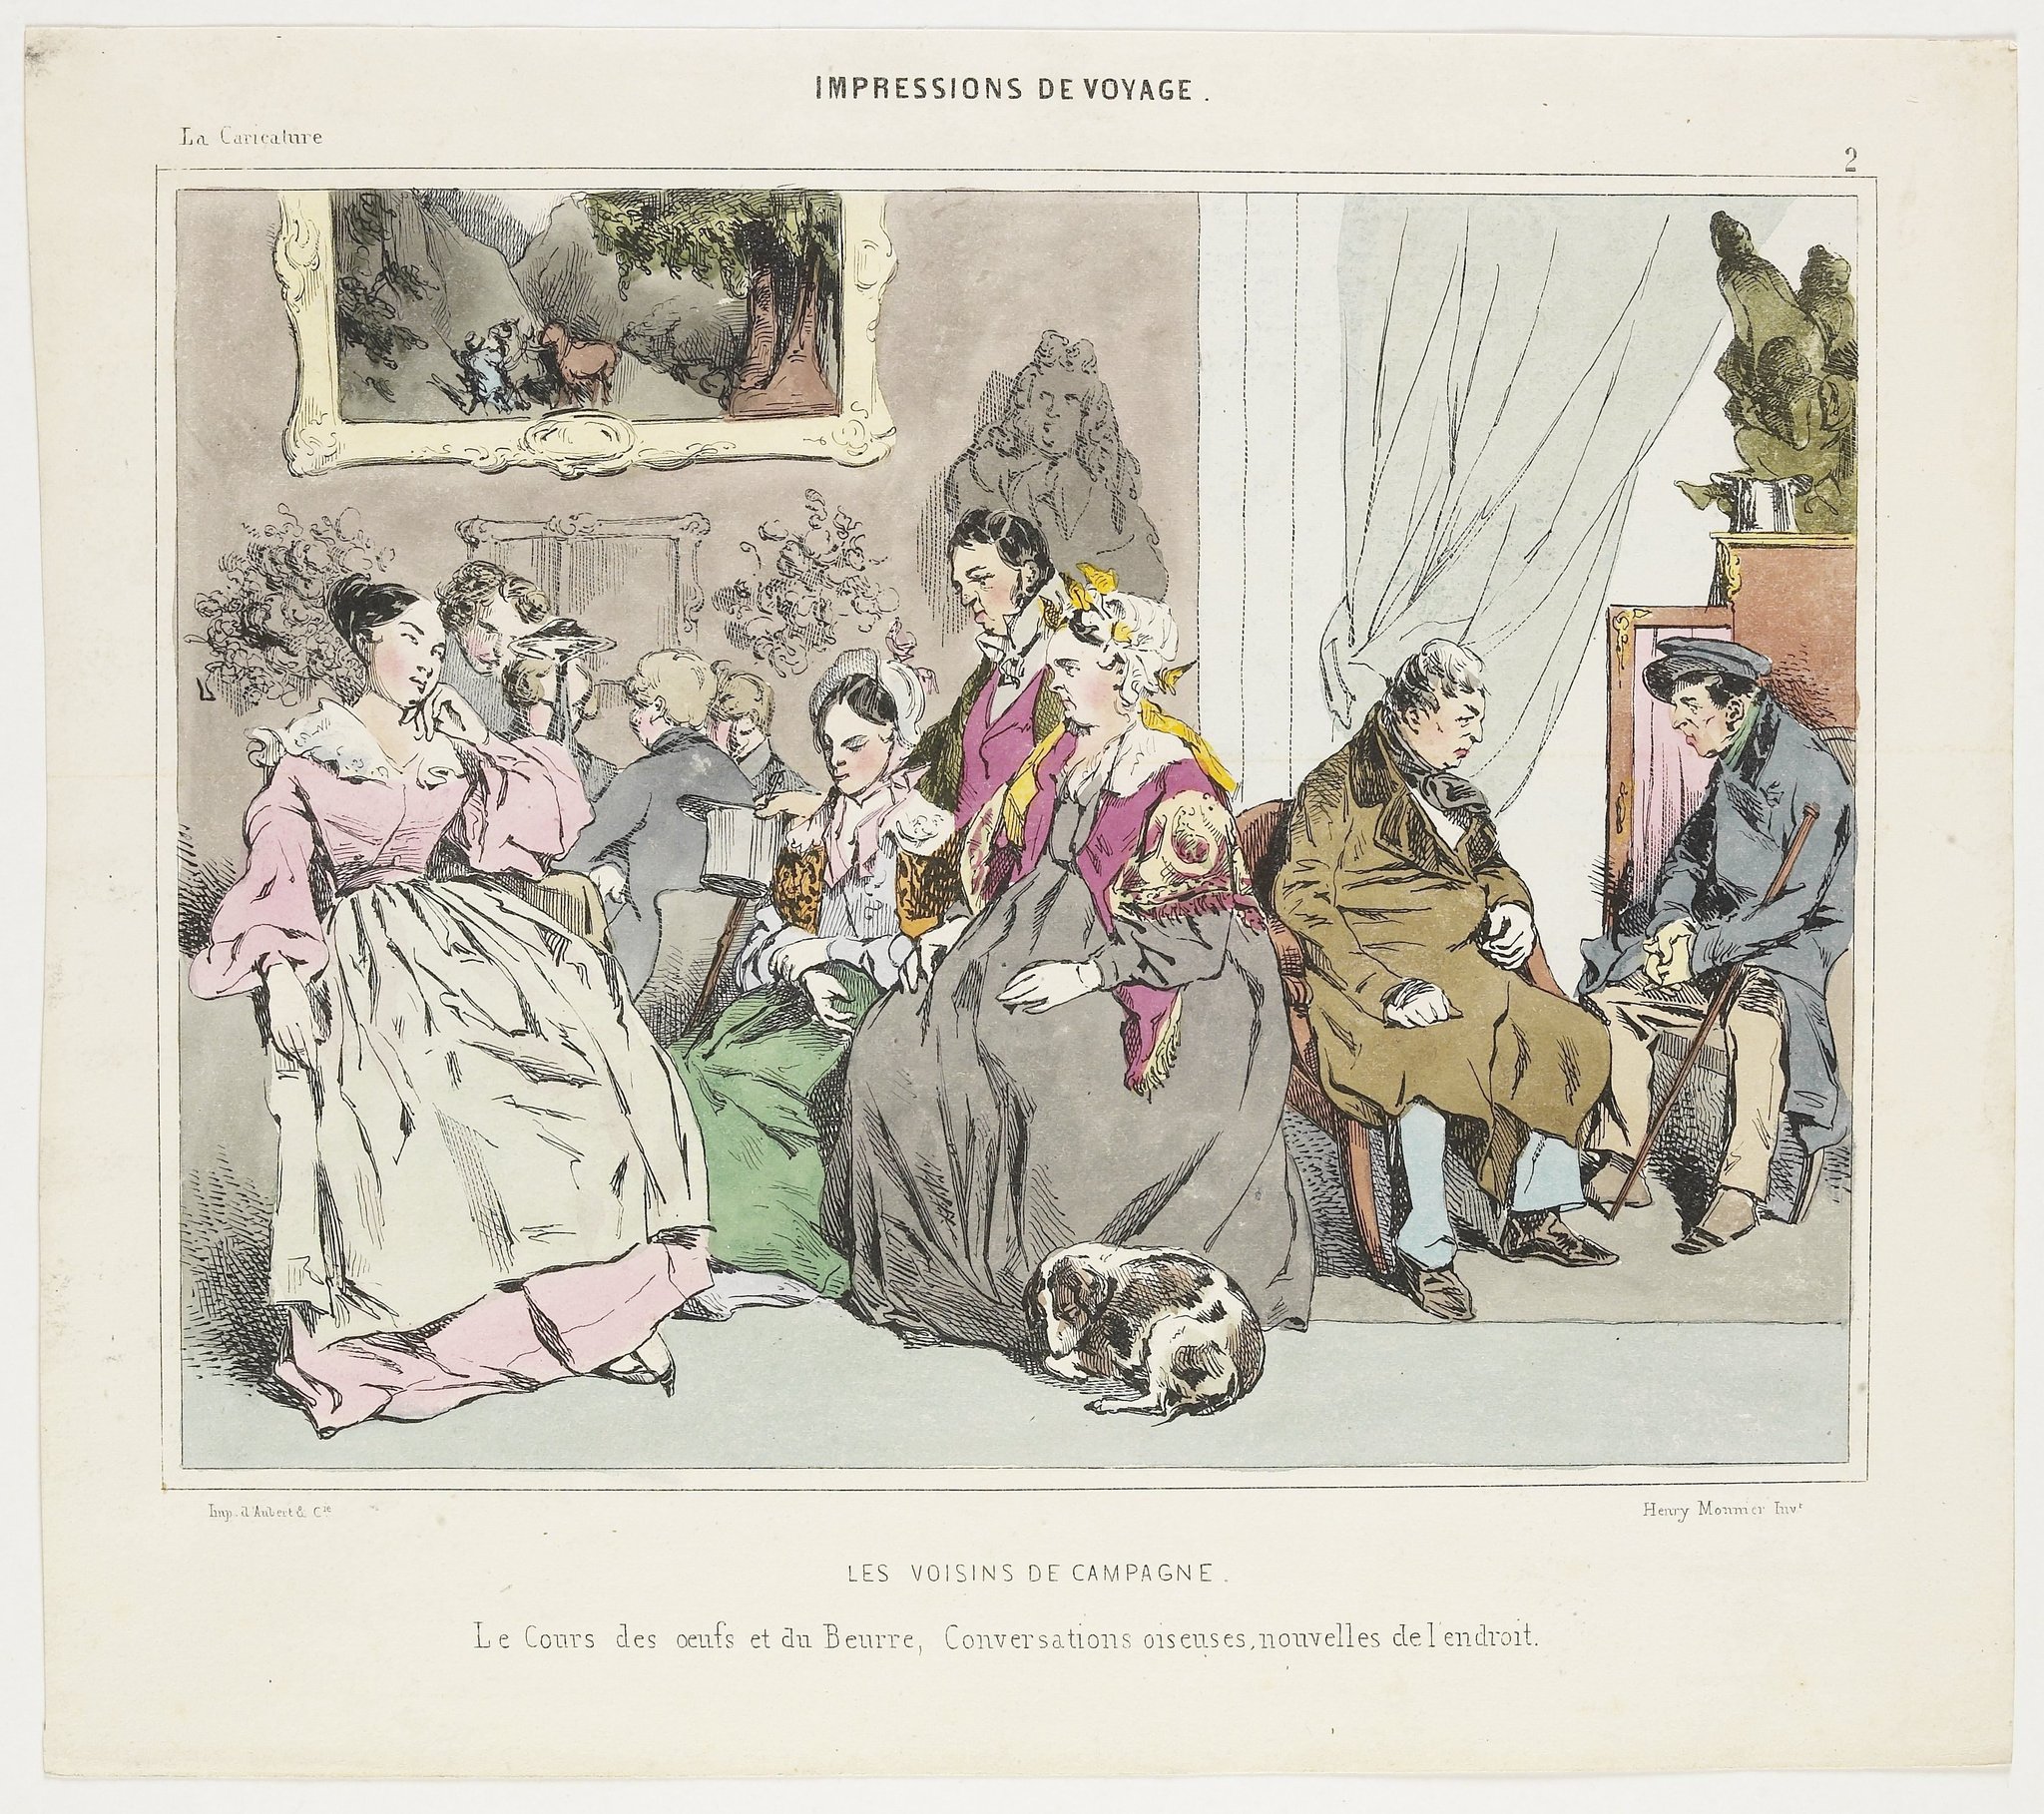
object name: cartoon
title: Impressions de voyage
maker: henry bonaventure monnier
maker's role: draughtsman, print maker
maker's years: 1799-1877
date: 1839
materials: paper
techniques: hand coloring, lithograph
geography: paris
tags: sitting figure (+ more than eight persons)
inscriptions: collector's mark: Lugt 2228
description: Gezelschap dames en heren buigt zich over de koers van eieren en boter en andere nieuwtjes uit de streek.